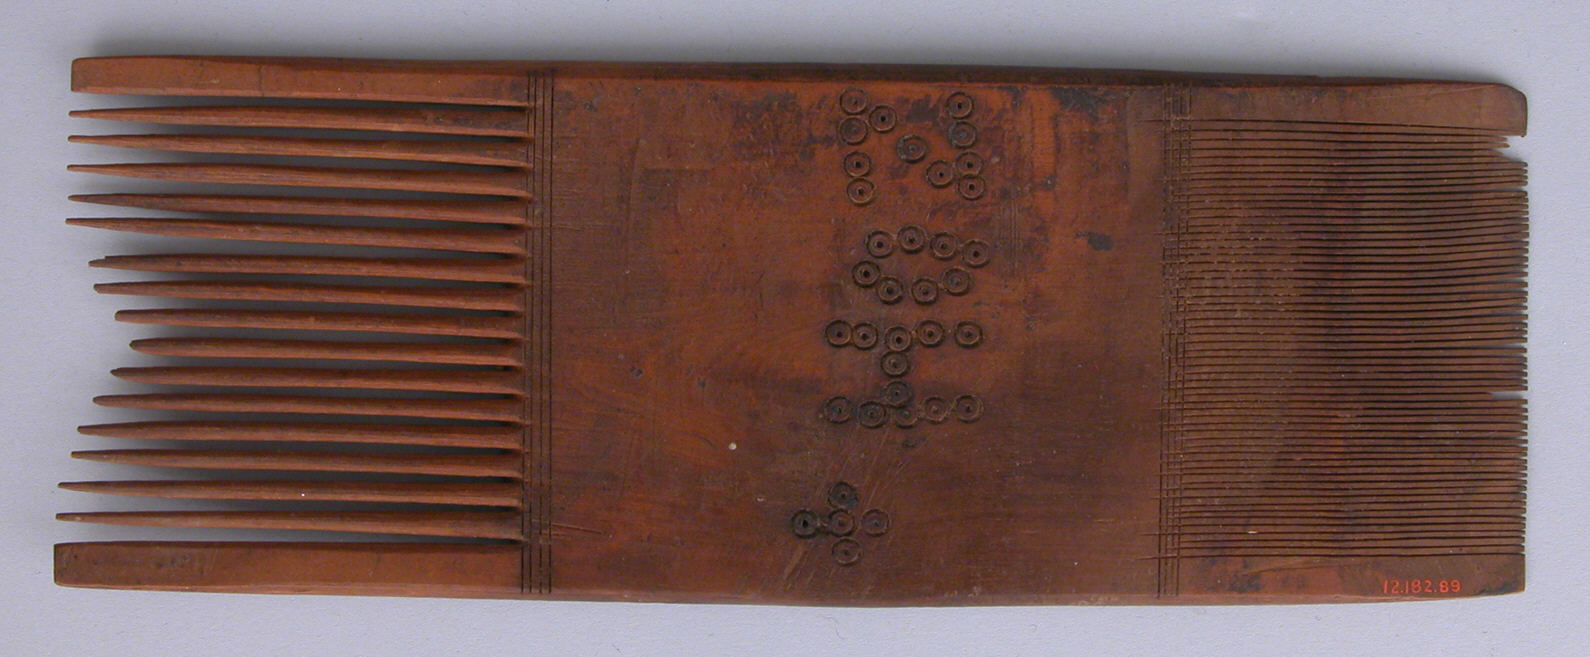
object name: comb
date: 601-800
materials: wood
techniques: carving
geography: egypt